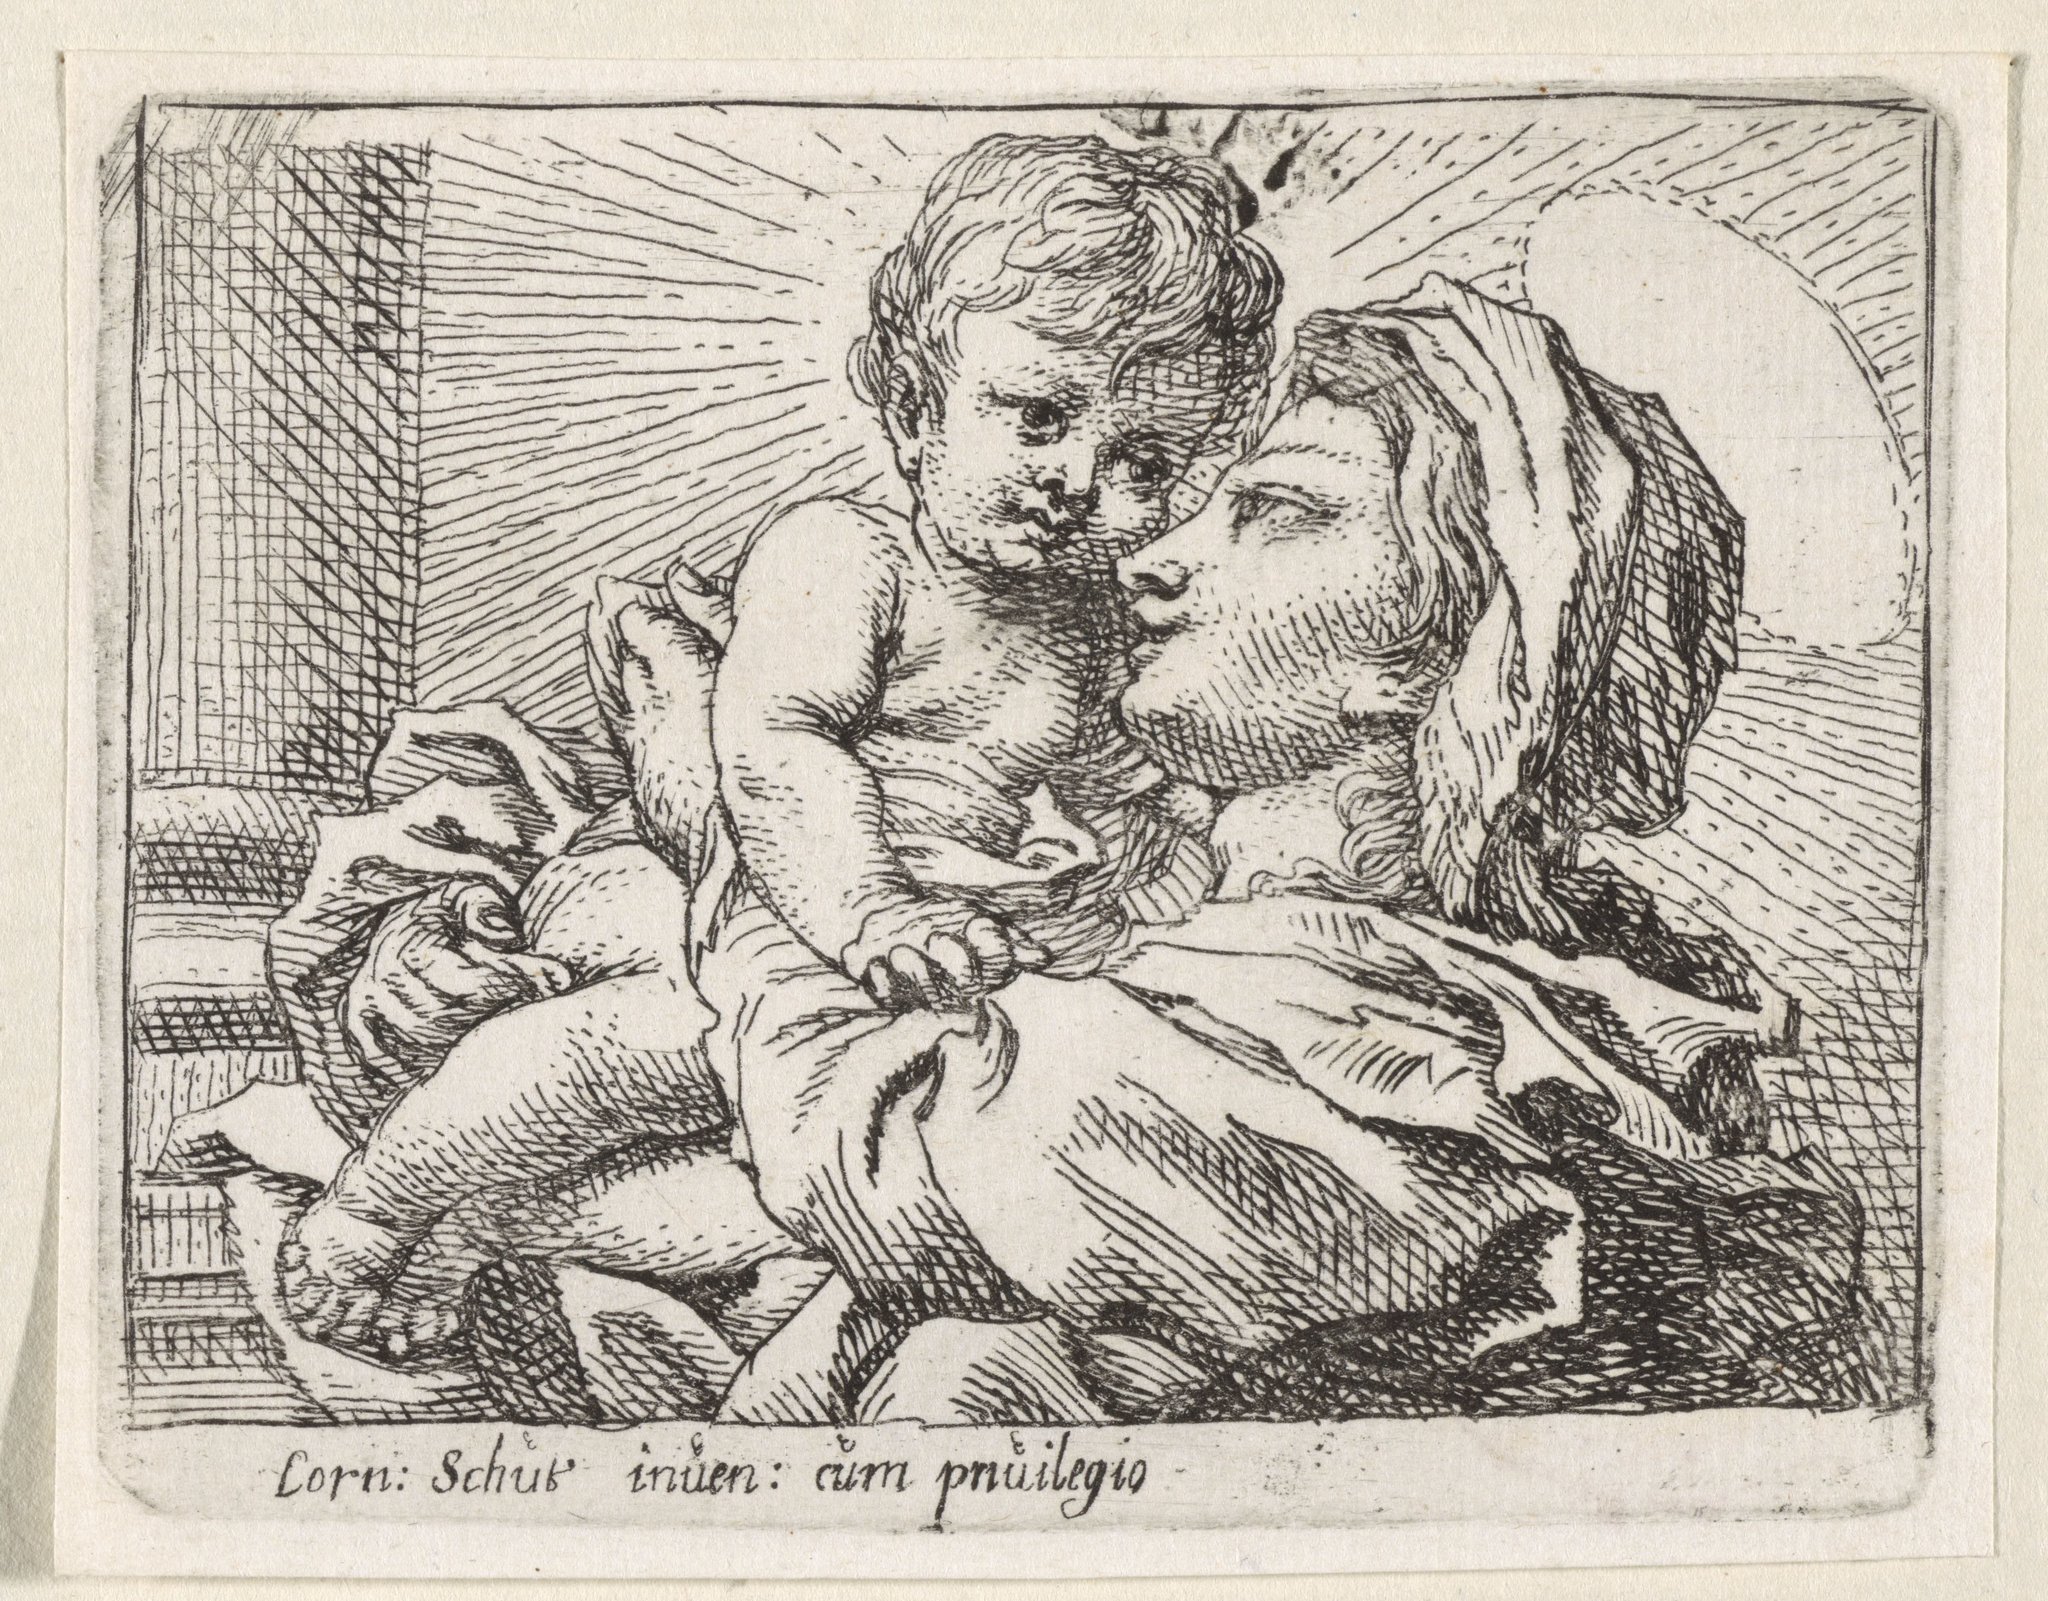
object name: print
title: Madonna met kind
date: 1618-1655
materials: paper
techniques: etching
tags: madonna: mary standing (or half-length), christ-child close to her bosom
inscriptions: collector's mark: Lugt 240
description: Maria tilt het Christuskind hoog op haar arm. Links een zuil.